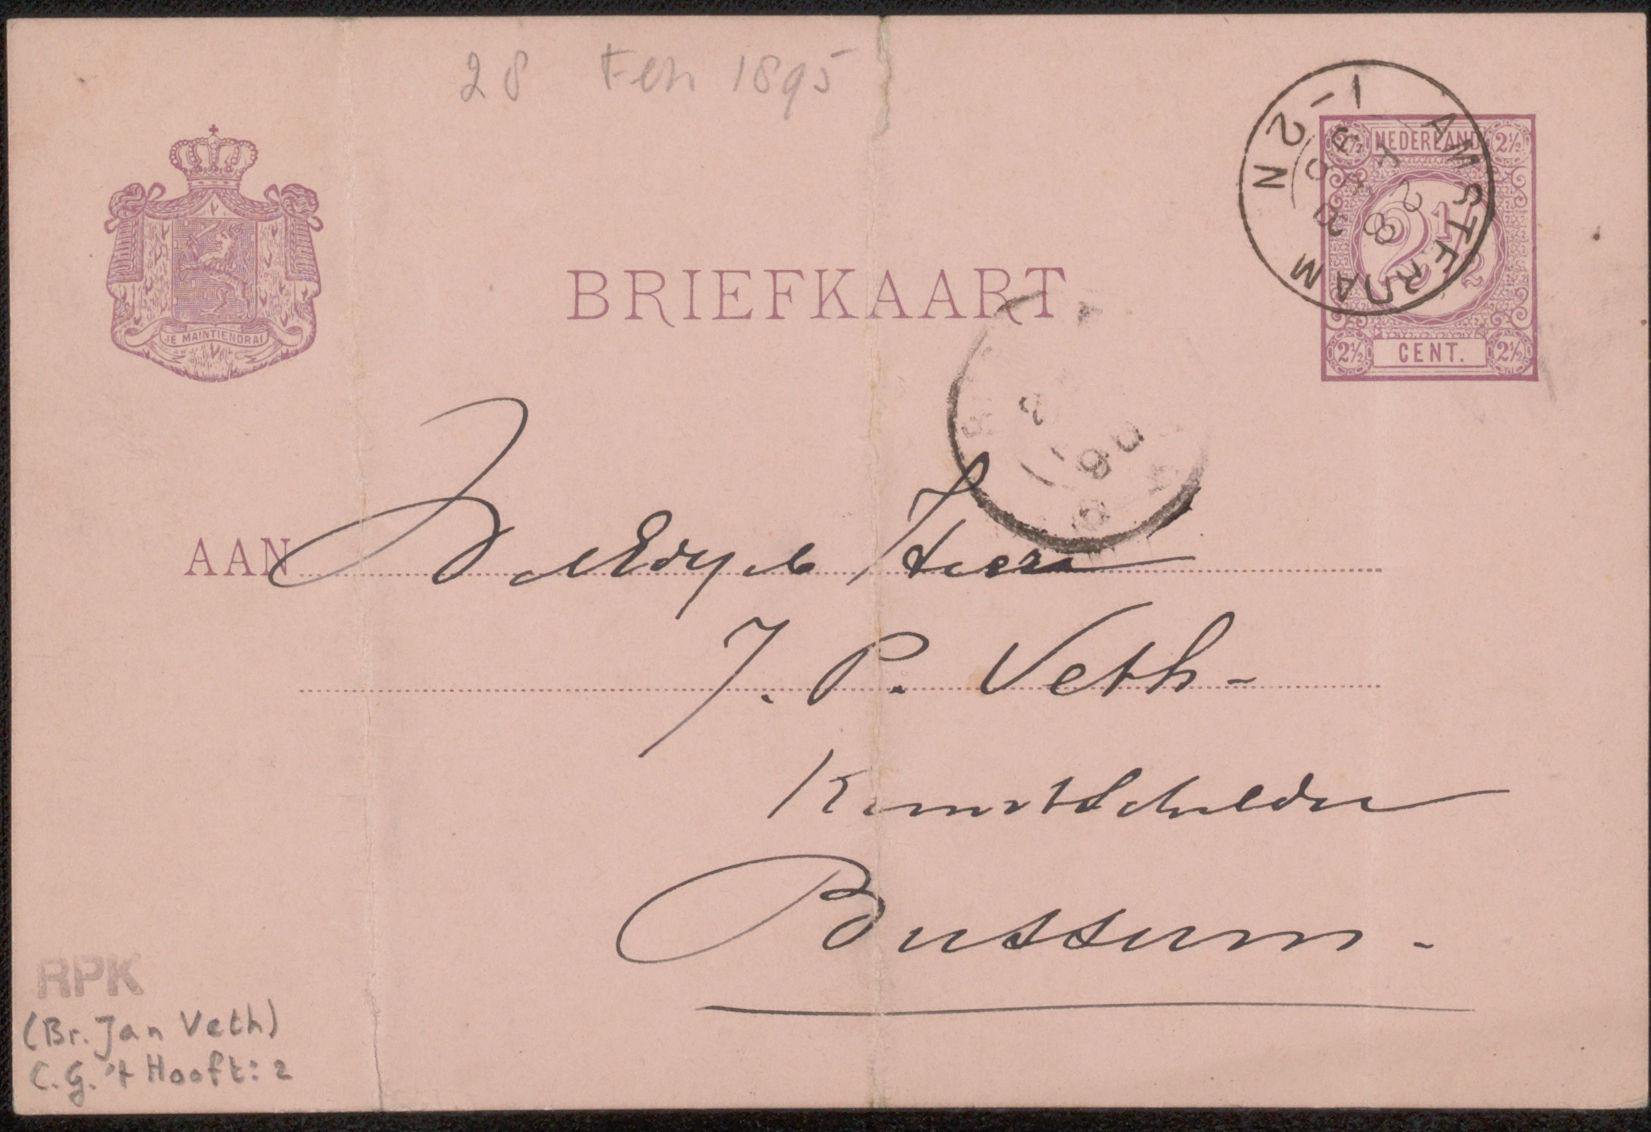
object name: postcard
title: Briefkaart aan Jan Veth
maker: cornelis gerardus t hooft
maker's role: draughtsman, painter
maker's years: 1866-1936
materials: cardboard, ink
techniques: pen, writing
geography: amsterdam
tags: delft, painter, draughtsman, johannes vermeer, print maker, designer, jan veth, berlin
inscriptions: collector's mark: ‘RPK’